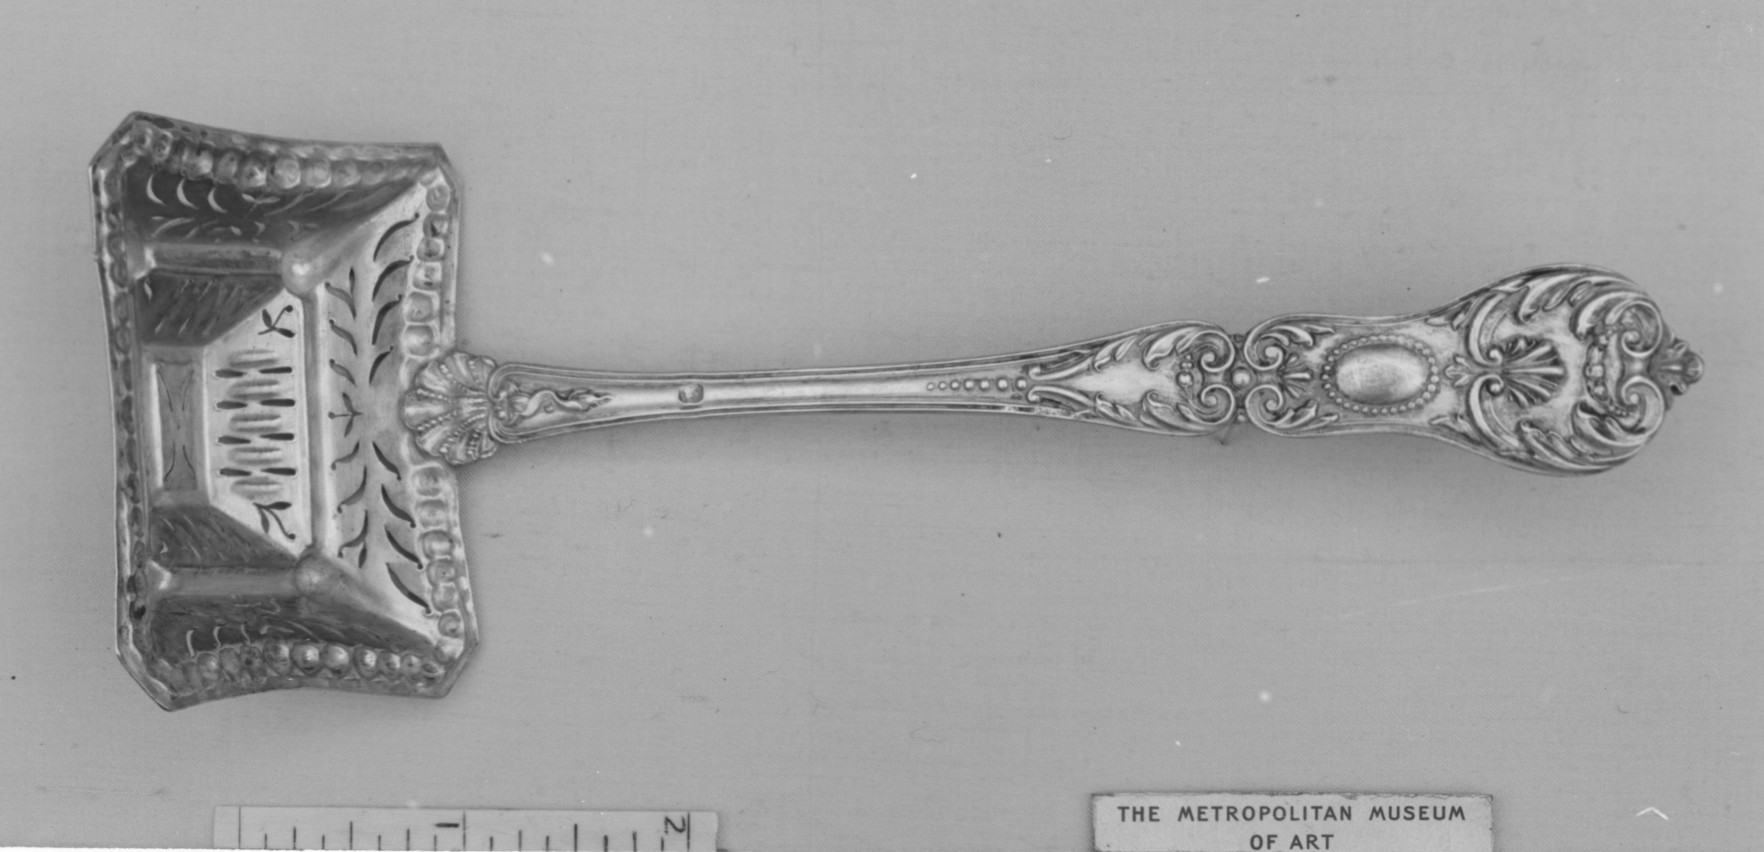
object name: sugar spoon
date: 1834-1866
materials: silver